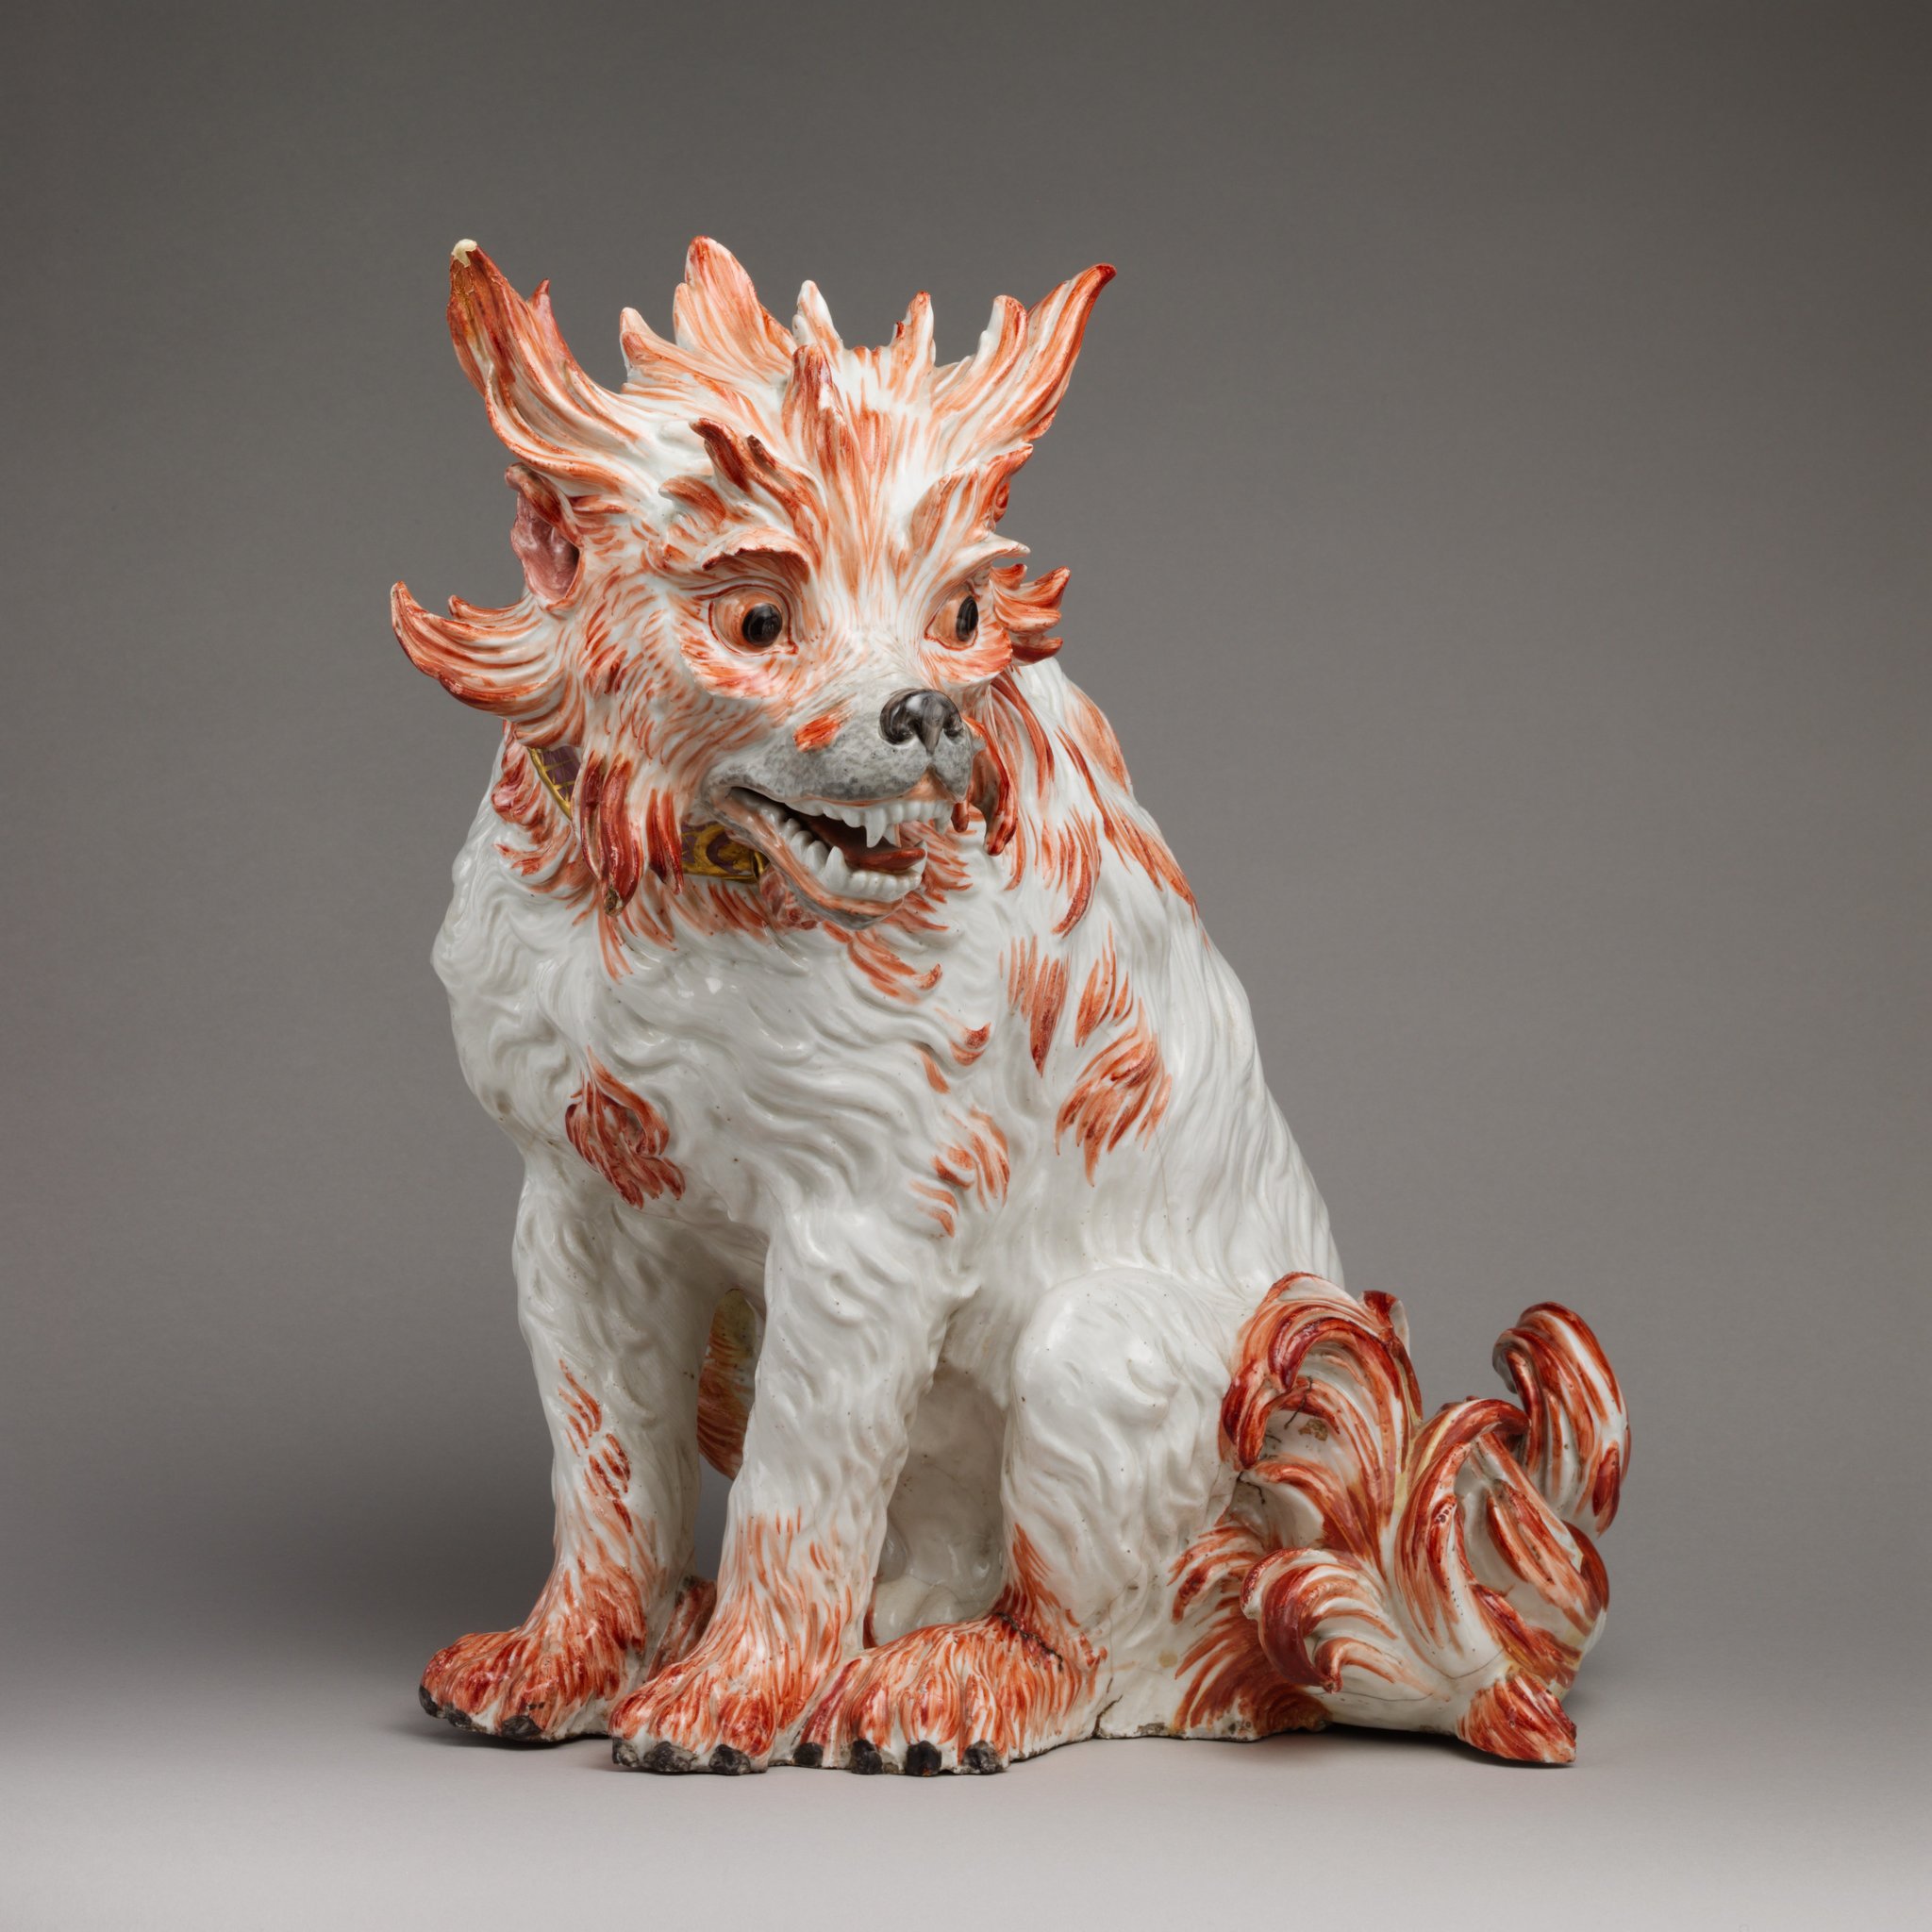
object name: figure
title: Bolognese dog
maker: meissen manufactory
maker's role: manufactory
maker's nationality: german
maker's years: 1710-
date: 1733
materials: hard paste porcelain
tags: dogs